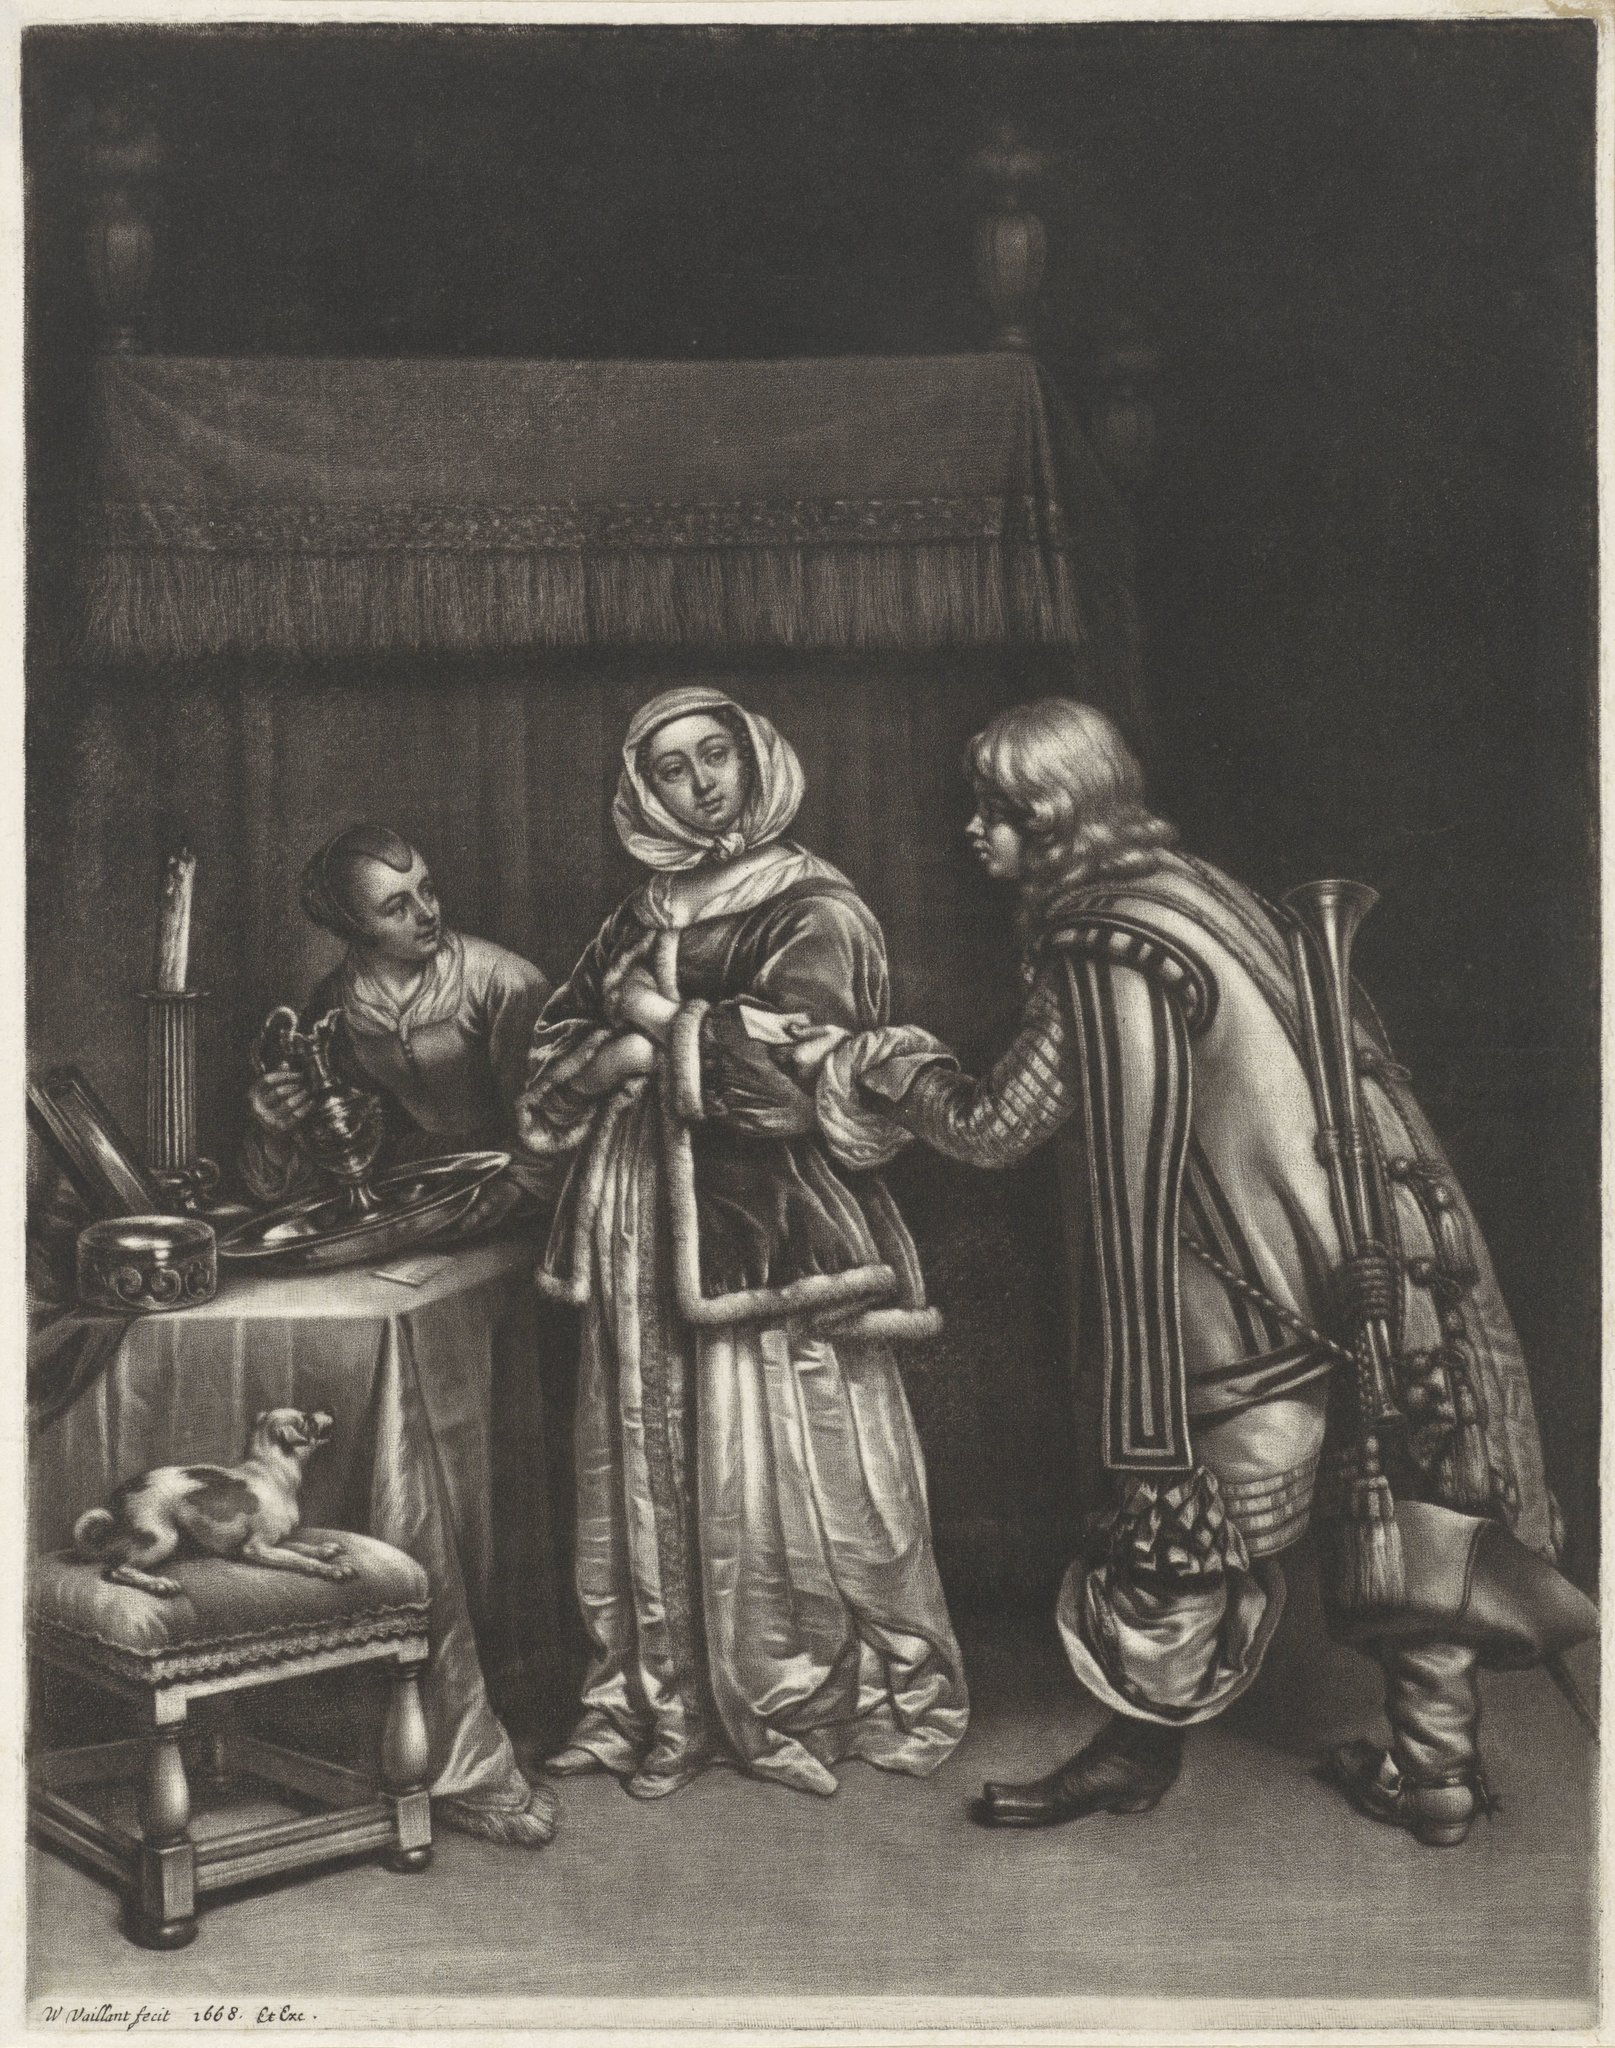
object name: print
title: Geweigerde brief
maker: wallerant vaillant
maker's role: draughtsman, painter, print maker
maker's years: 1623-1677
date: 1668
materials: paper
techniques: mezzotint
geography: amsterdam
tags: letter, envelope, dog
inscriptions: collector's mark: Lugt 11, collector's mark: Lugt 10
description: Een boodschapper, met op zijn rug een bazuin, reikt een vrouw een brief aan. Zij lijkt de brief niet aan te willen nemen, ze heeft haar armen over elkaar geslagen.